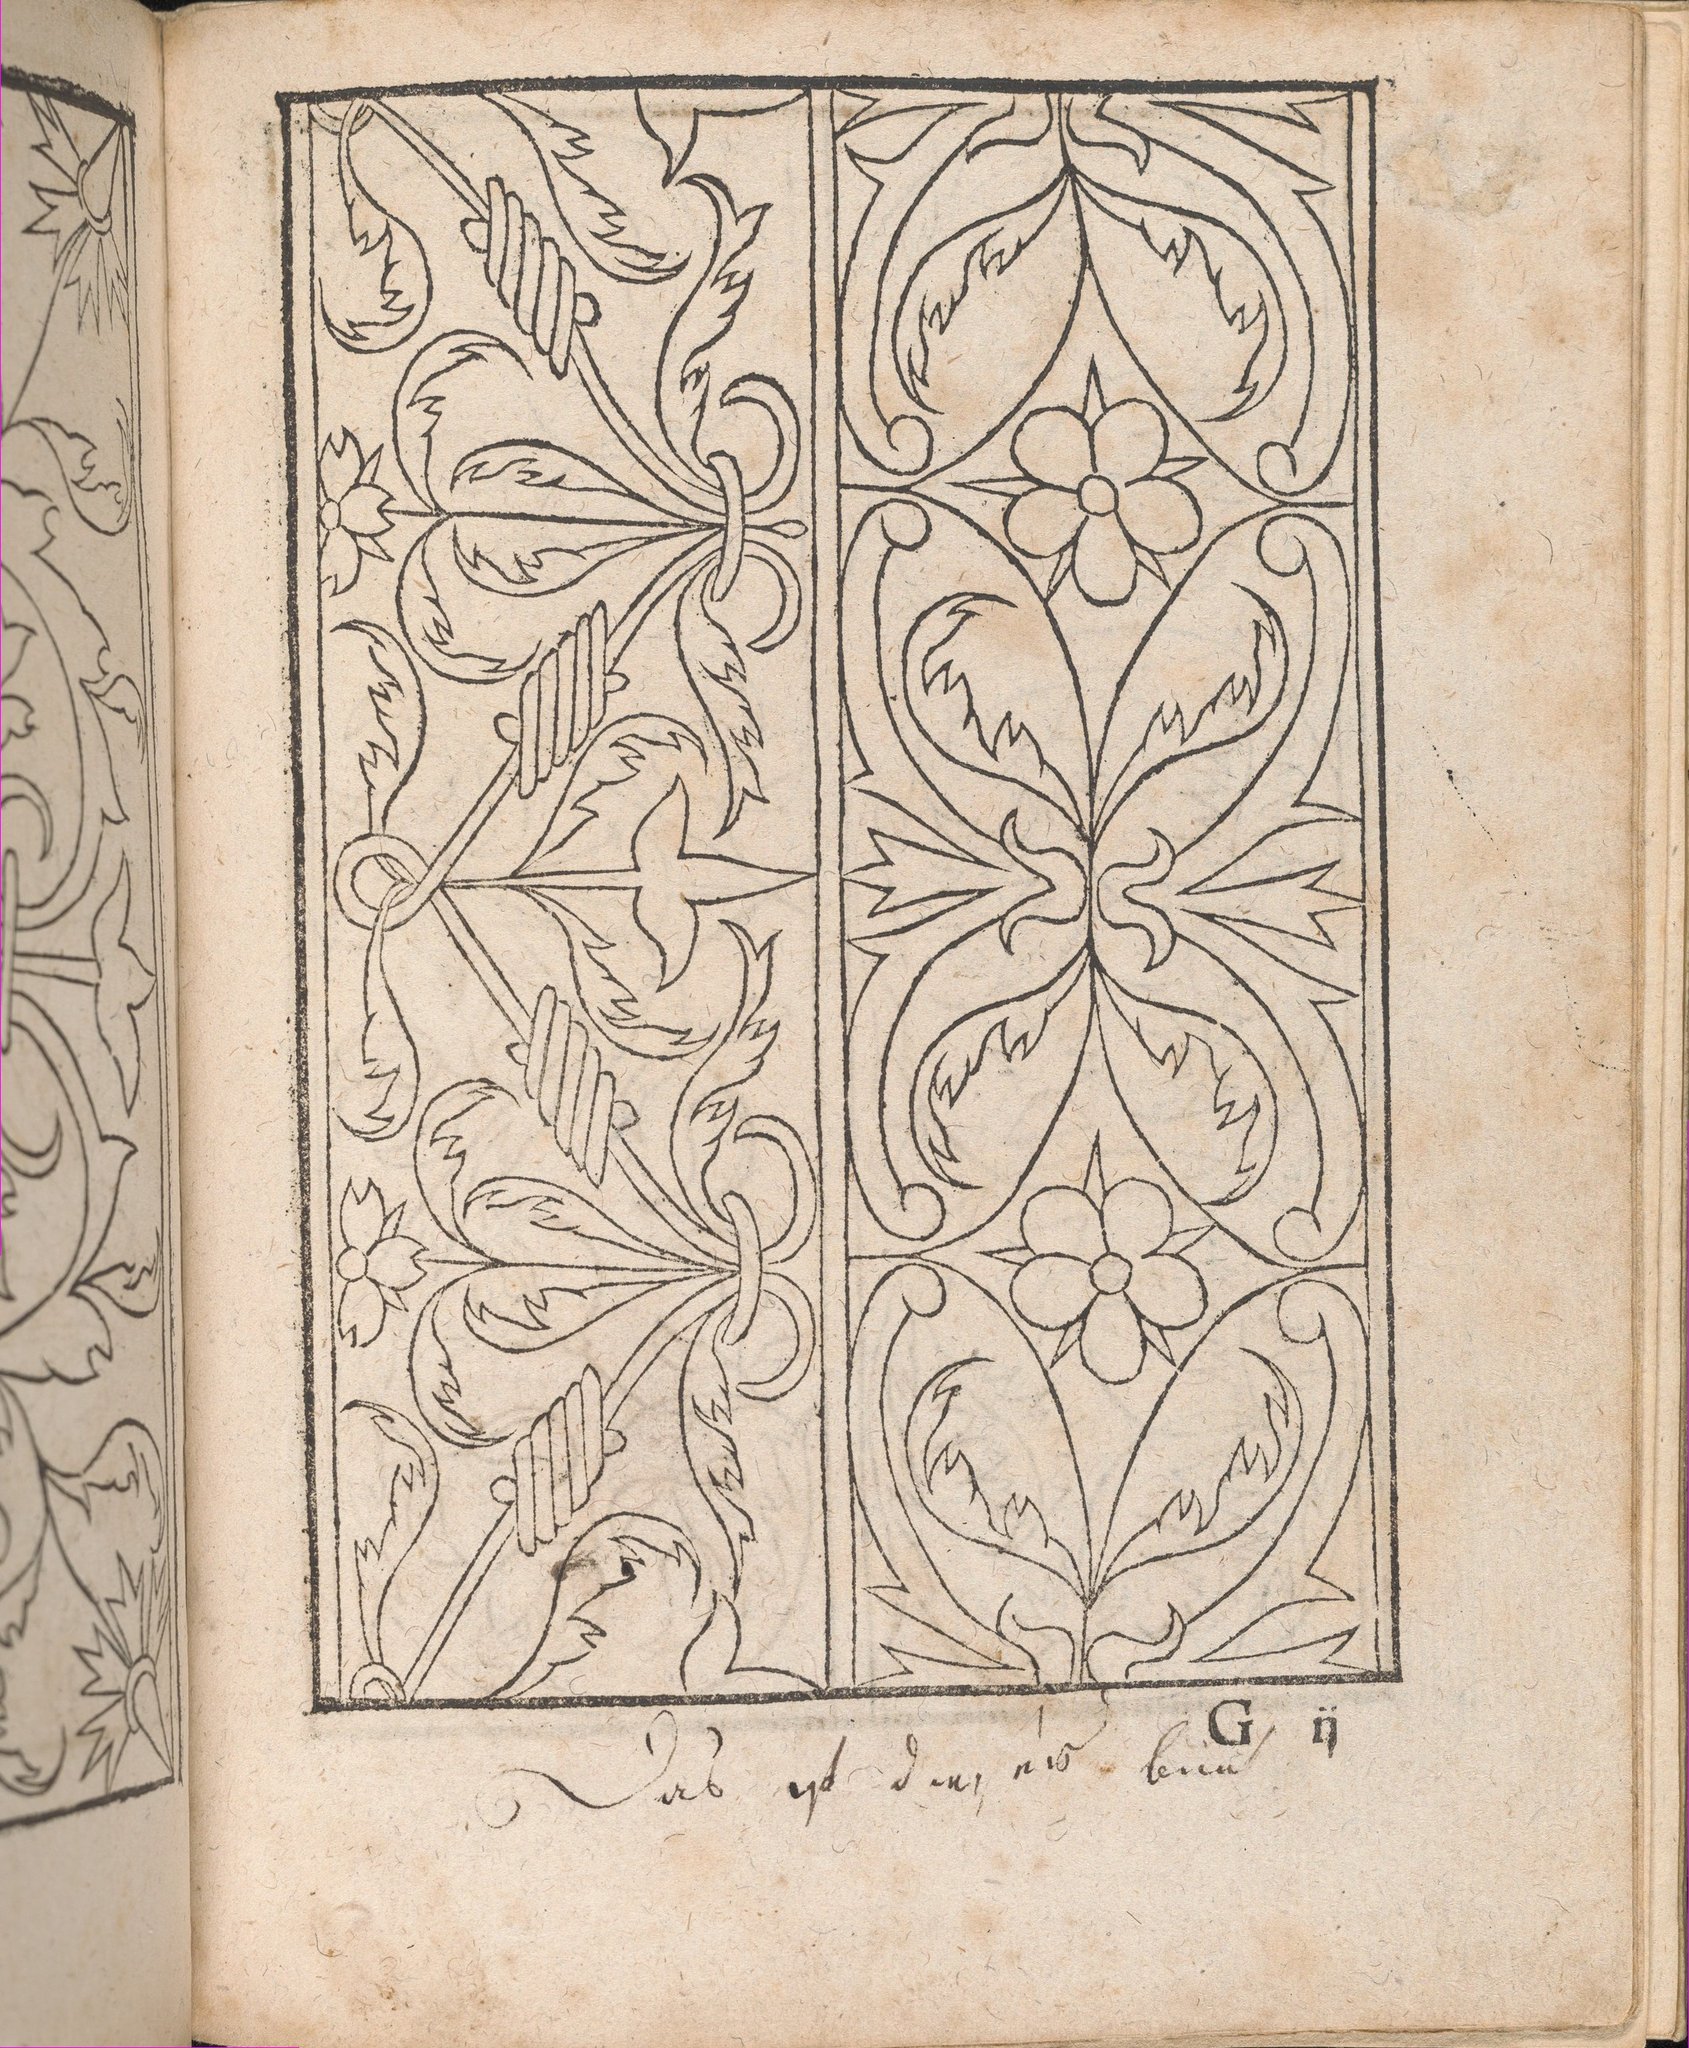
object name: book print ornament architecture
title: New Modelbüch allen Nägerin u. Sydenstickern (Page 26r)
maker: hans hoffman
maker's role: designer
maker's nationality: german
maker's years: 1556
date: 1556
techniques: woodcut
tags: flowers